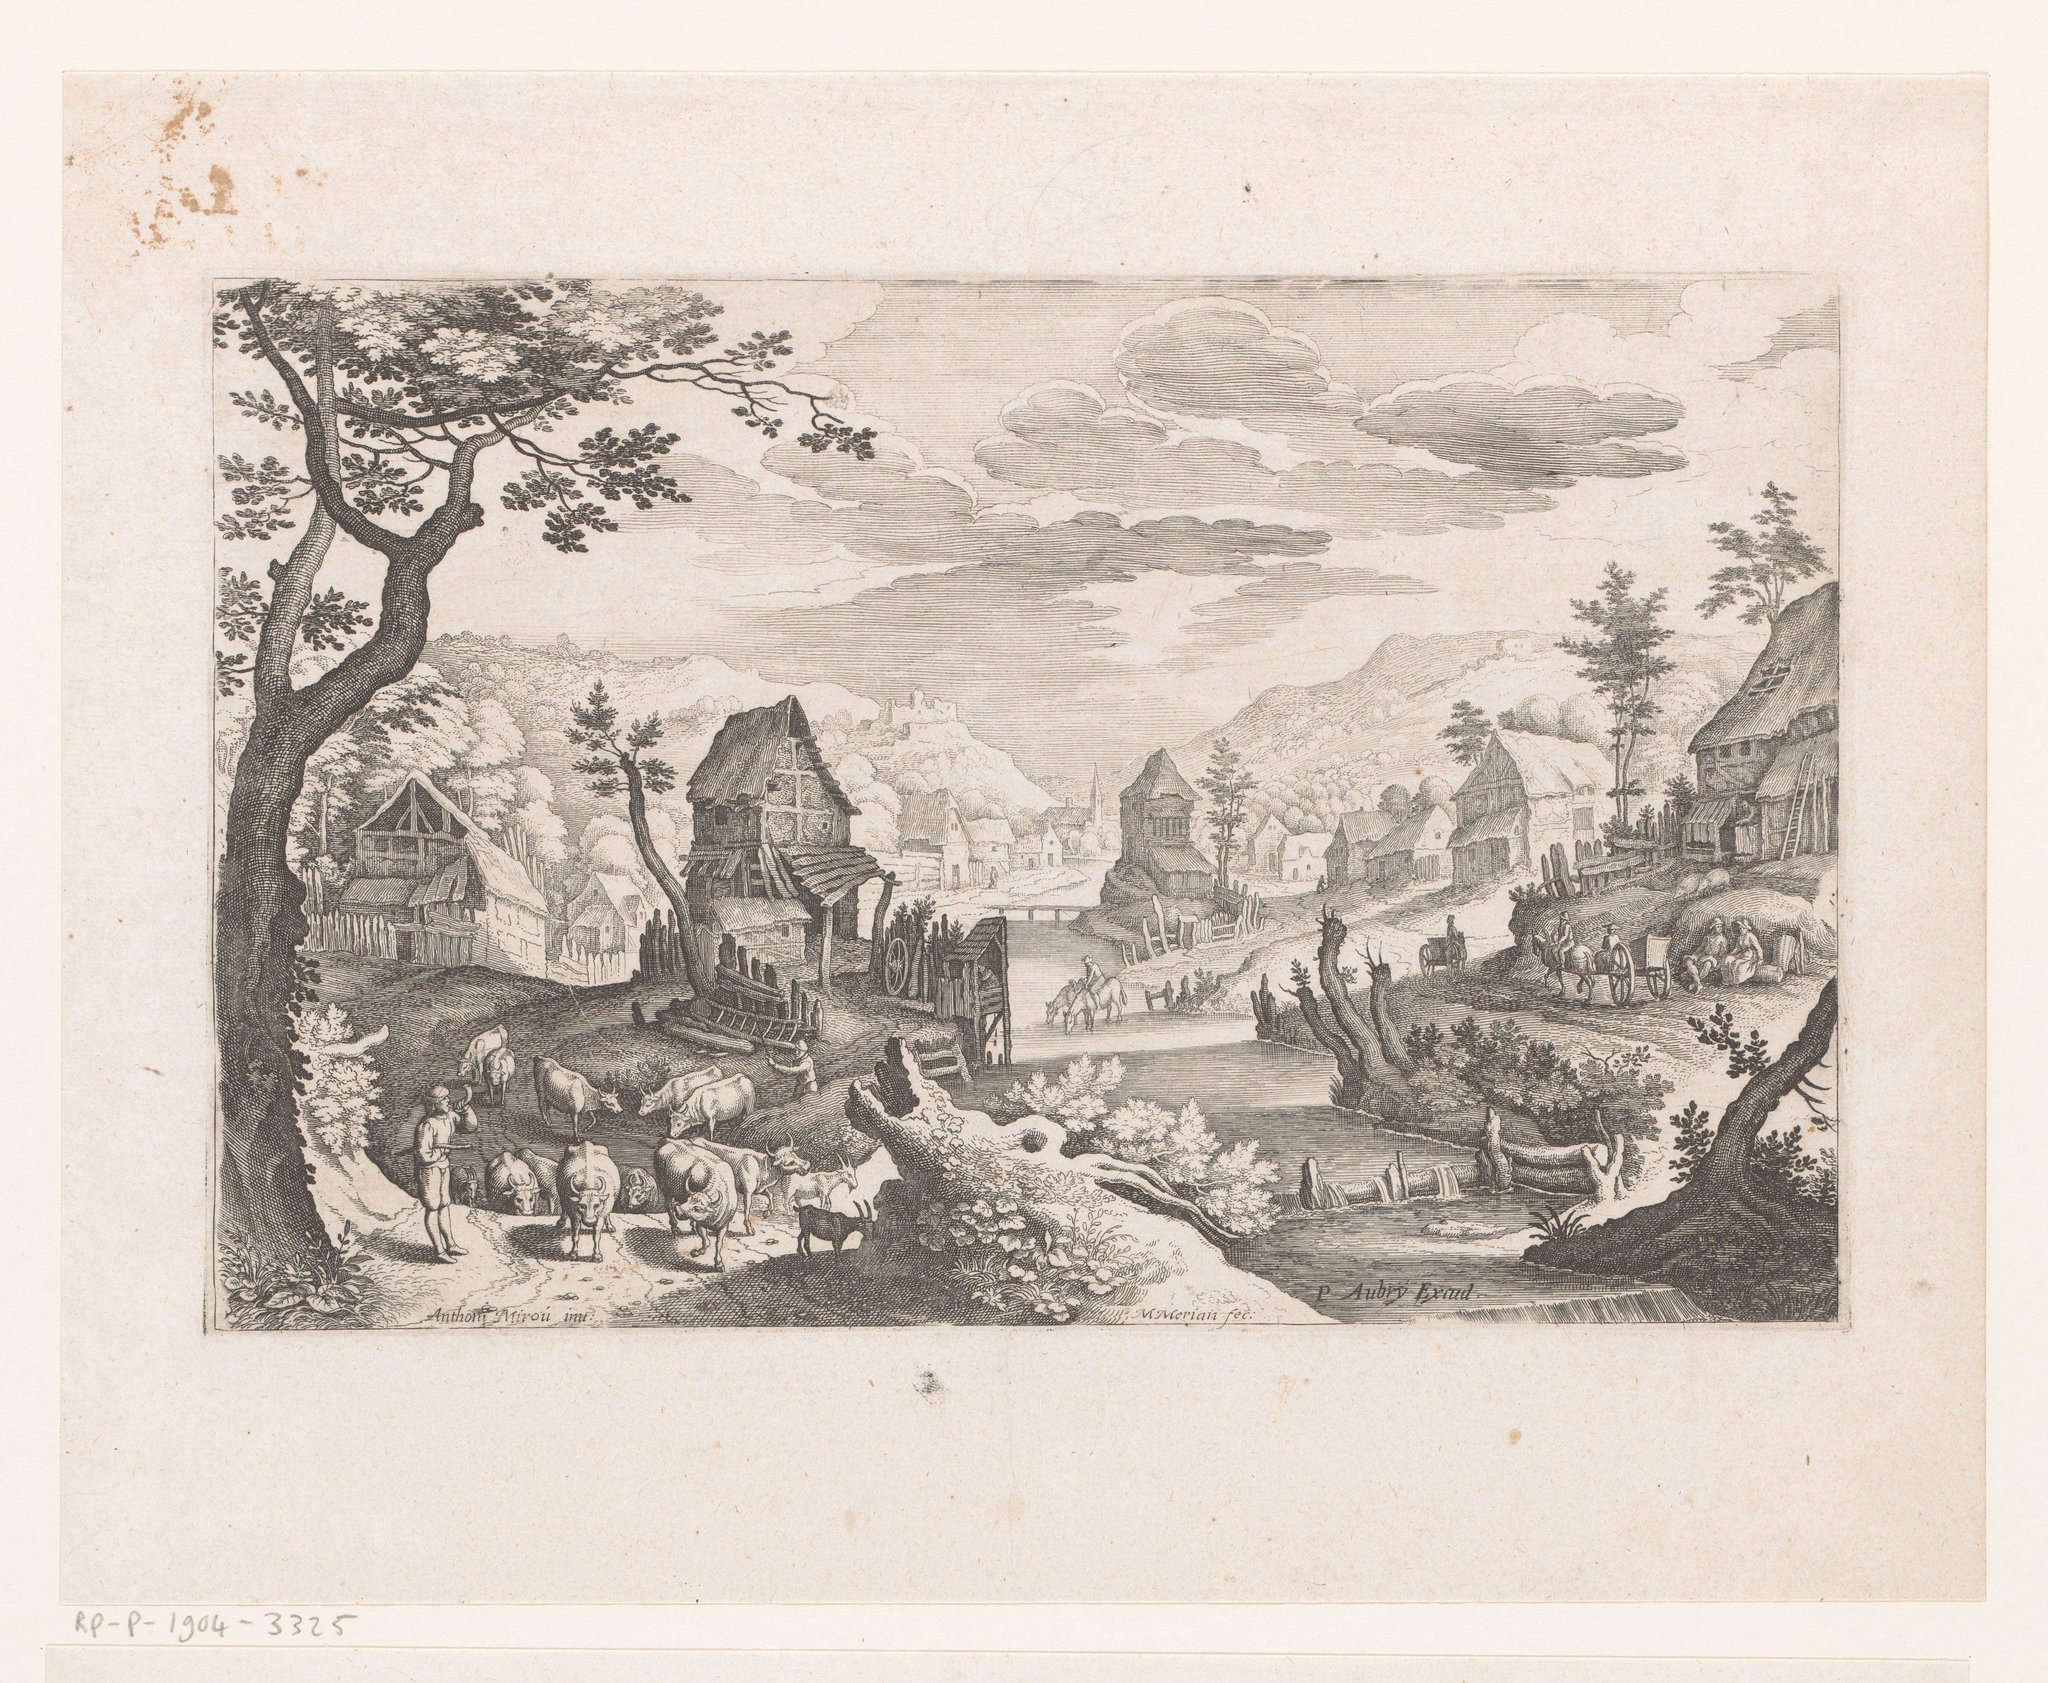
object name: print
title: Dorp in bergen met beek en veehoeder die op hoorn blaast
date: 1603-1650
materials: paper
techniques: etching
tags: herding, herdsman, herdswoman, shepherd, shepherdess, cowherd, etc., landscapes with waters, waterscapes, seascapes (in the temperate zone), village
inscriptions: collector's mark: Lugt 2228